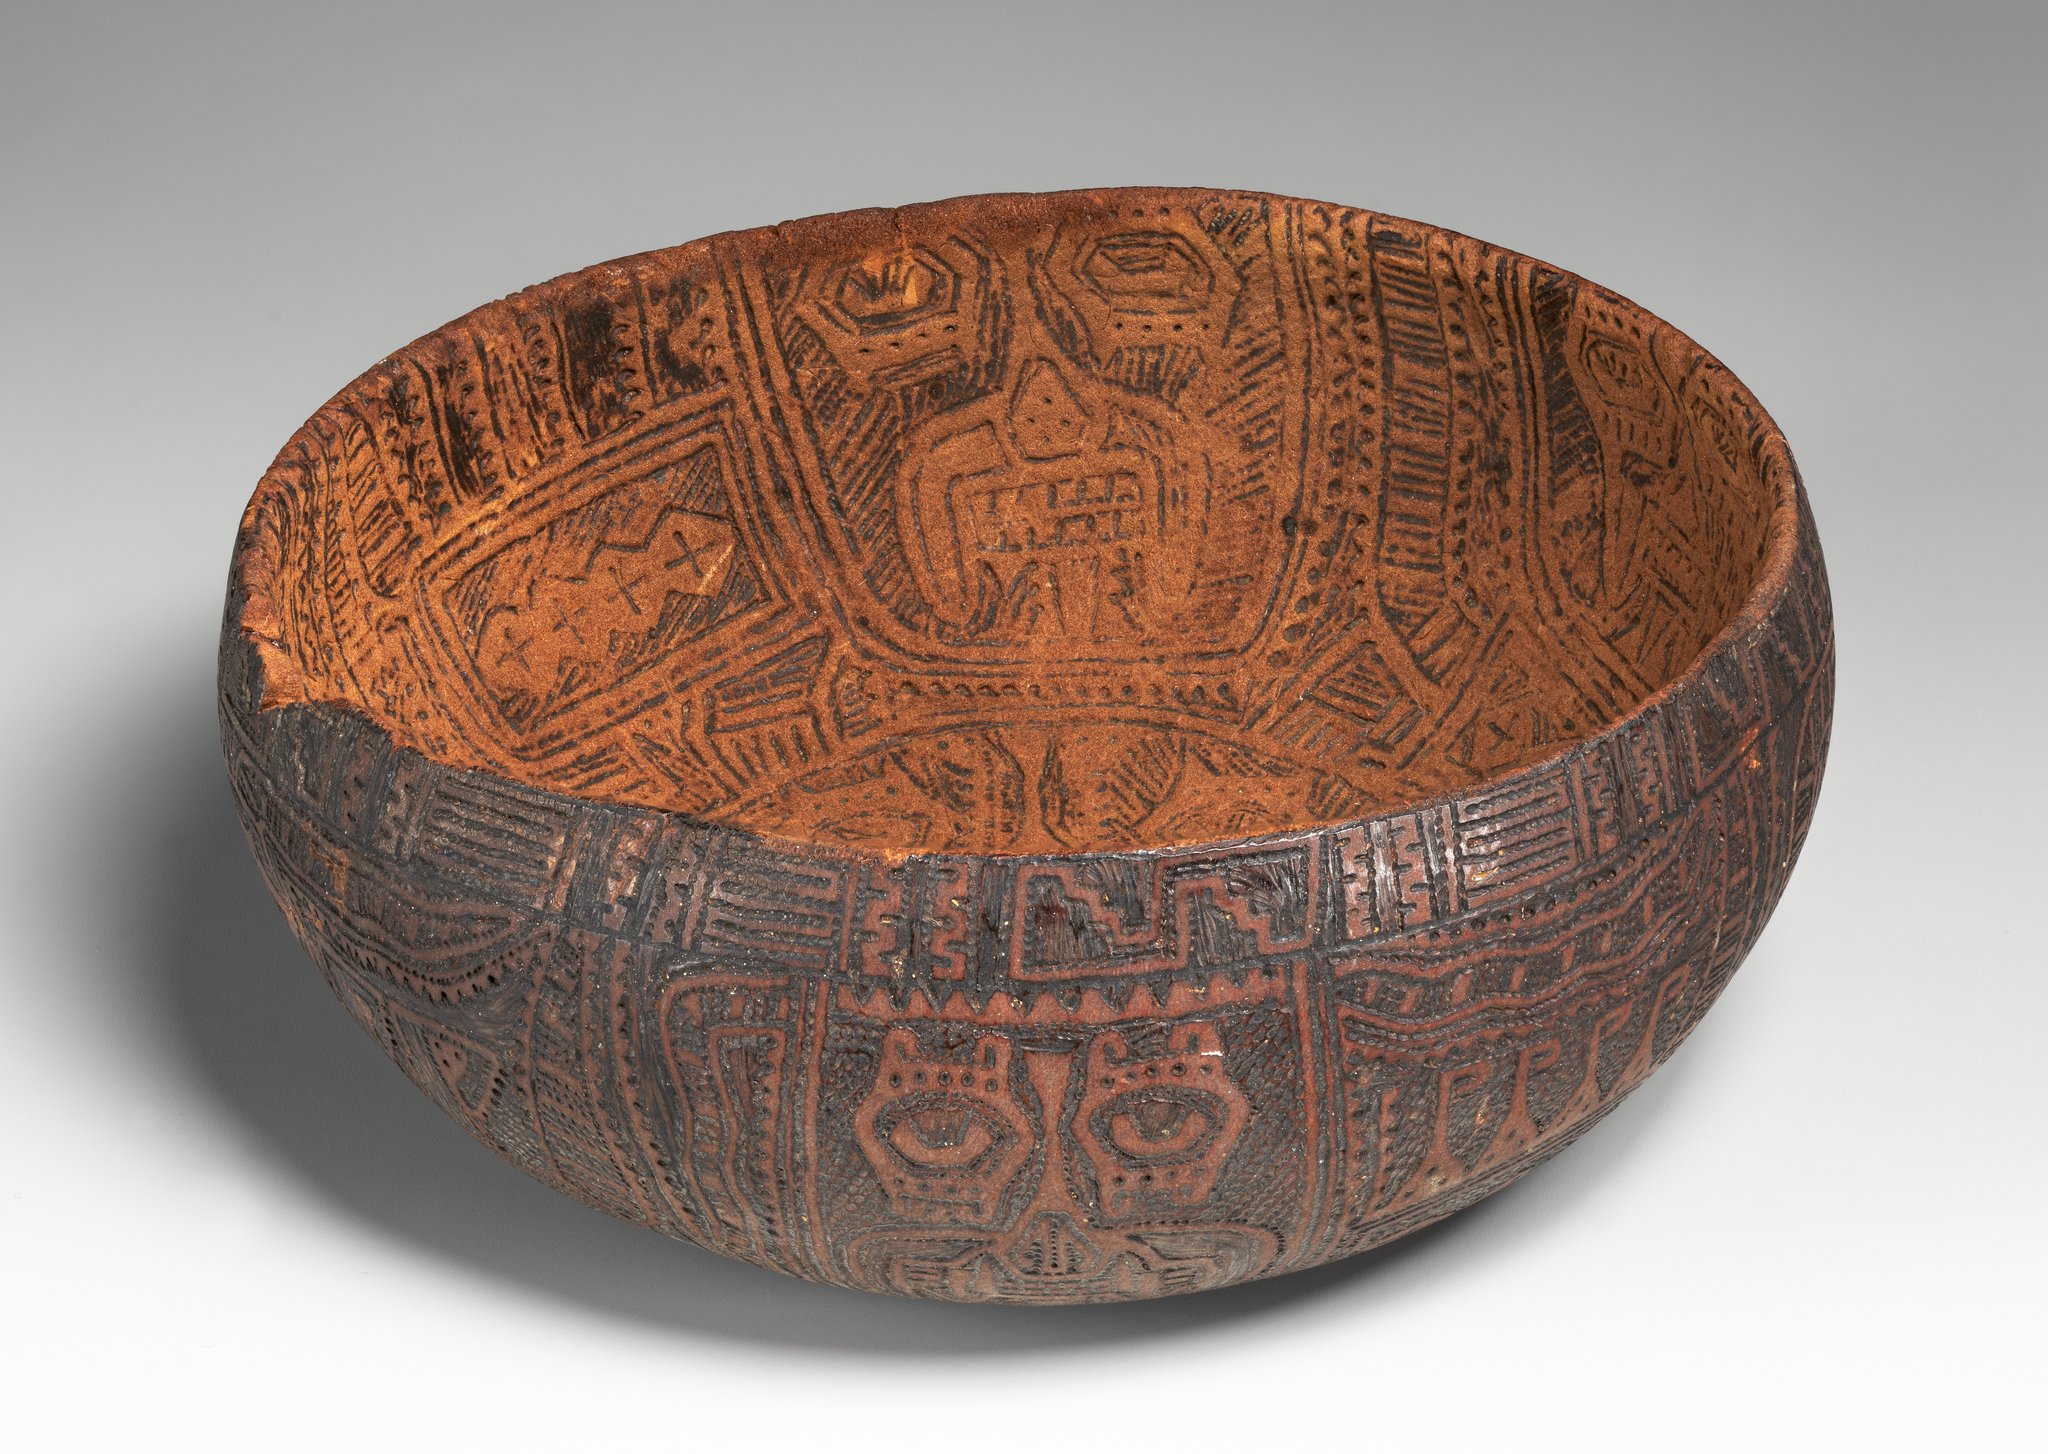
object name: bowl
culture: paracas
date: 500-301 BCE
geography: peru